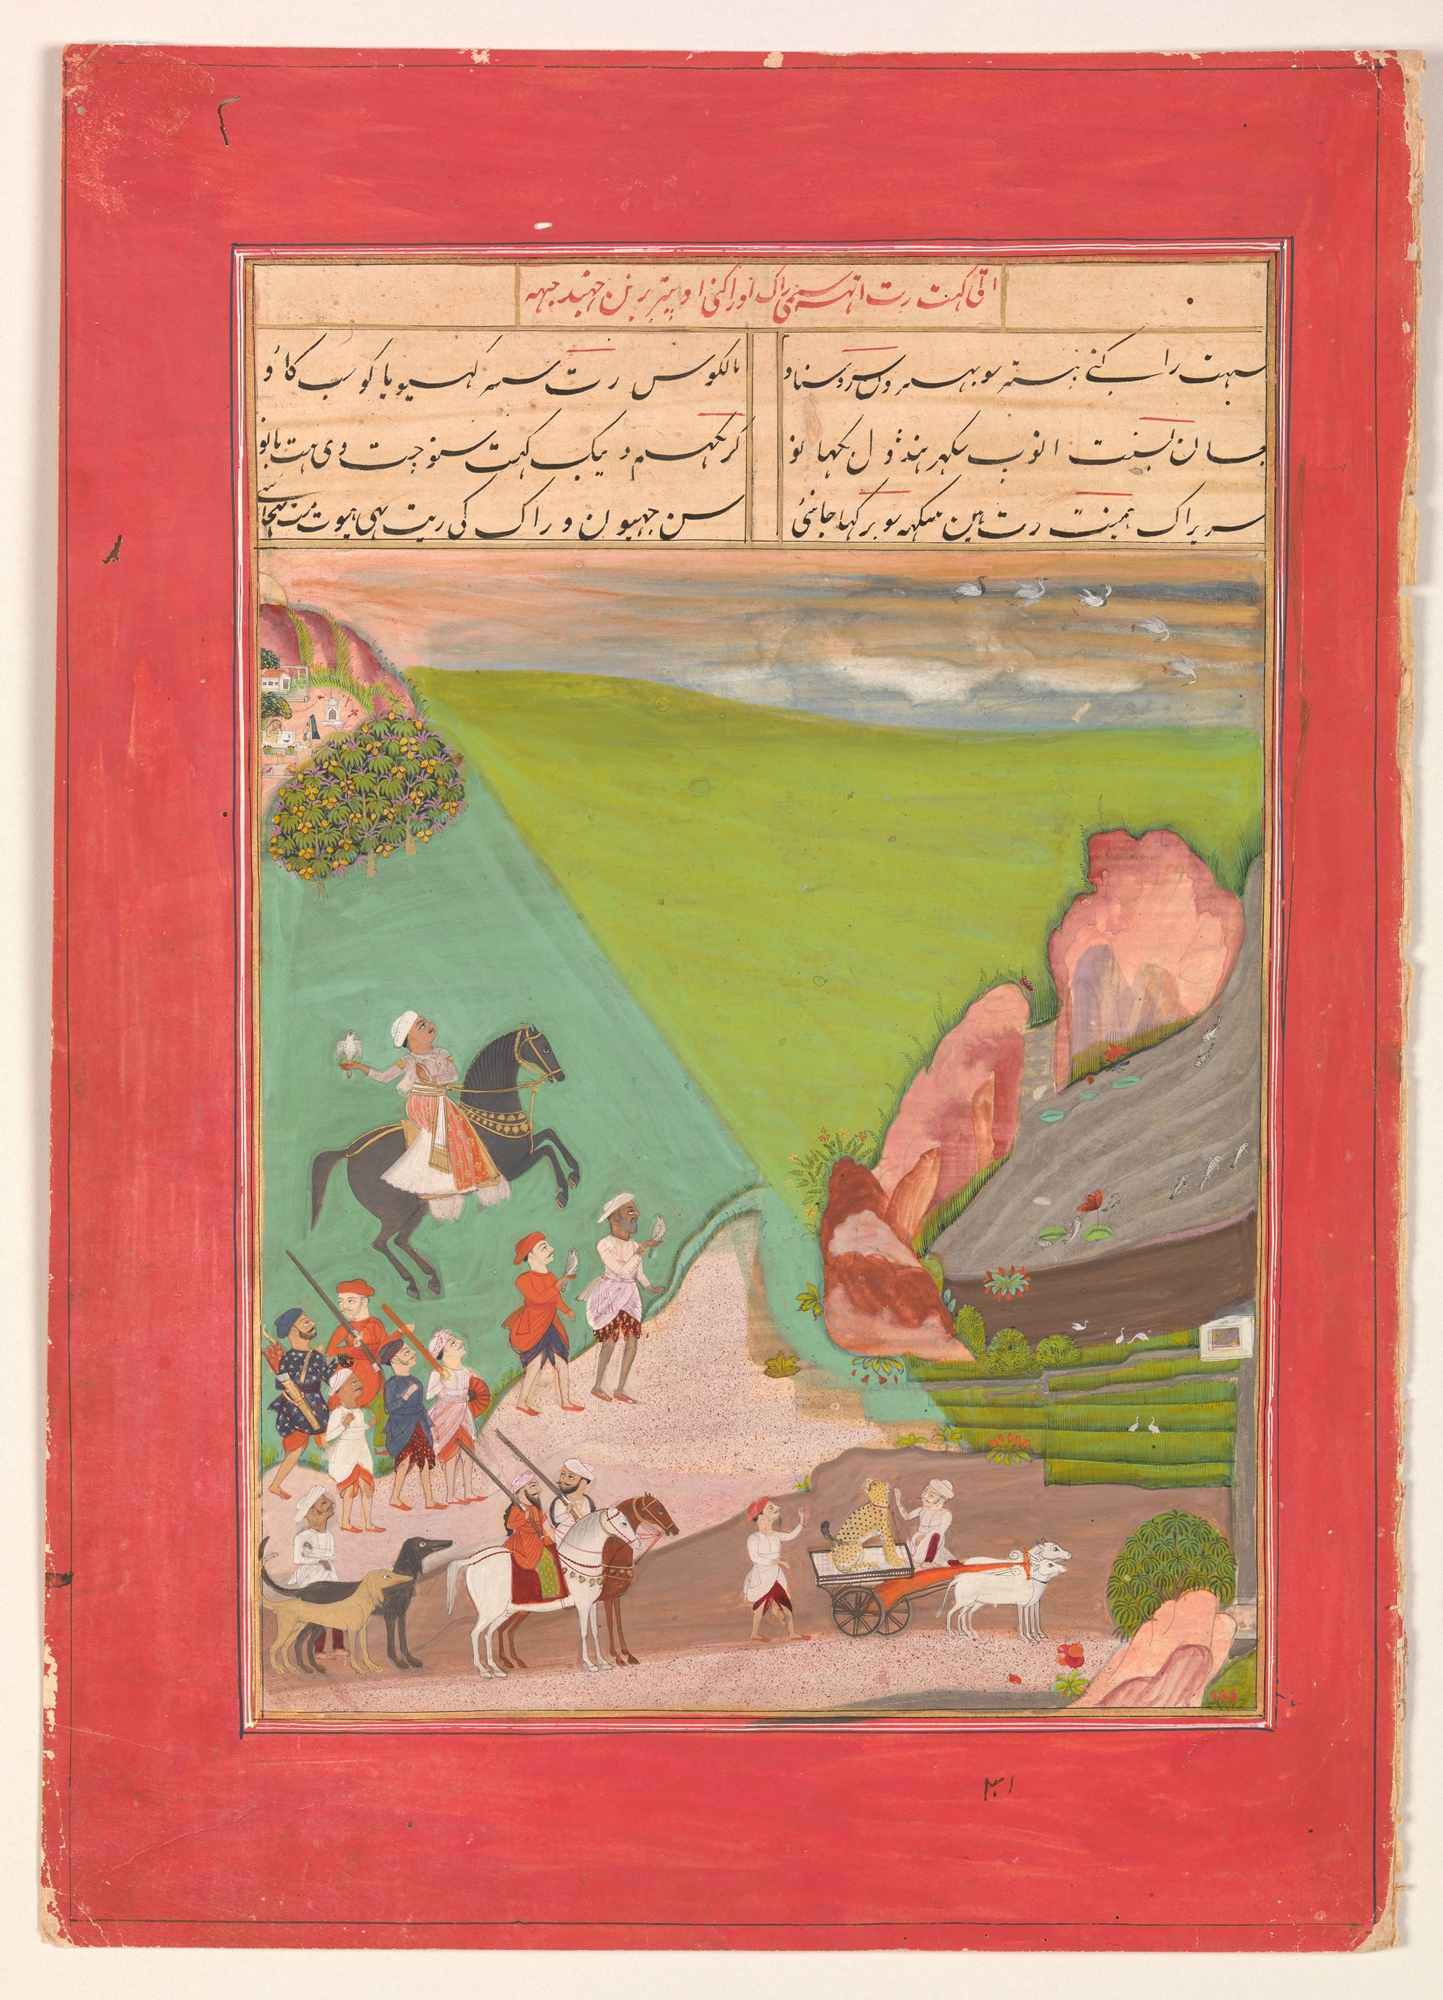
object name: folio from an illustrated manuscript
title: "A Prince out Hawking with a Group of Attendants and a Leopard", Folio from a manuscript of the Raga Darshan of Anup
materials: paper, watercolor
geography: india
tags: hawks,princes,men,dogs,horses,leopards